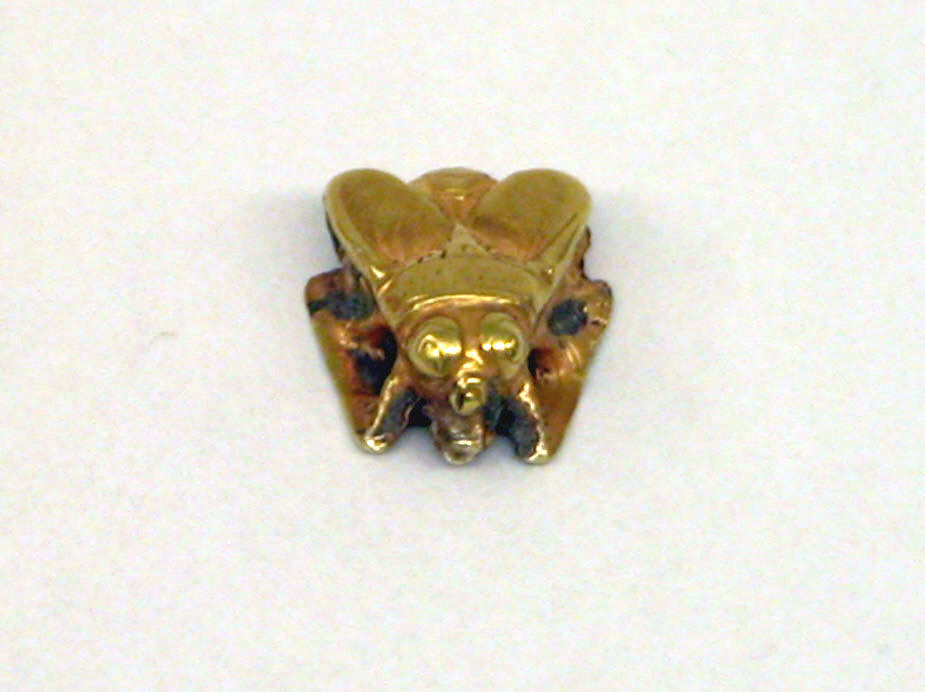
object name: ornament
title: Ornament in the Shape of a Bee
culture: indonesian, javanese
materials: gold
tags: bees